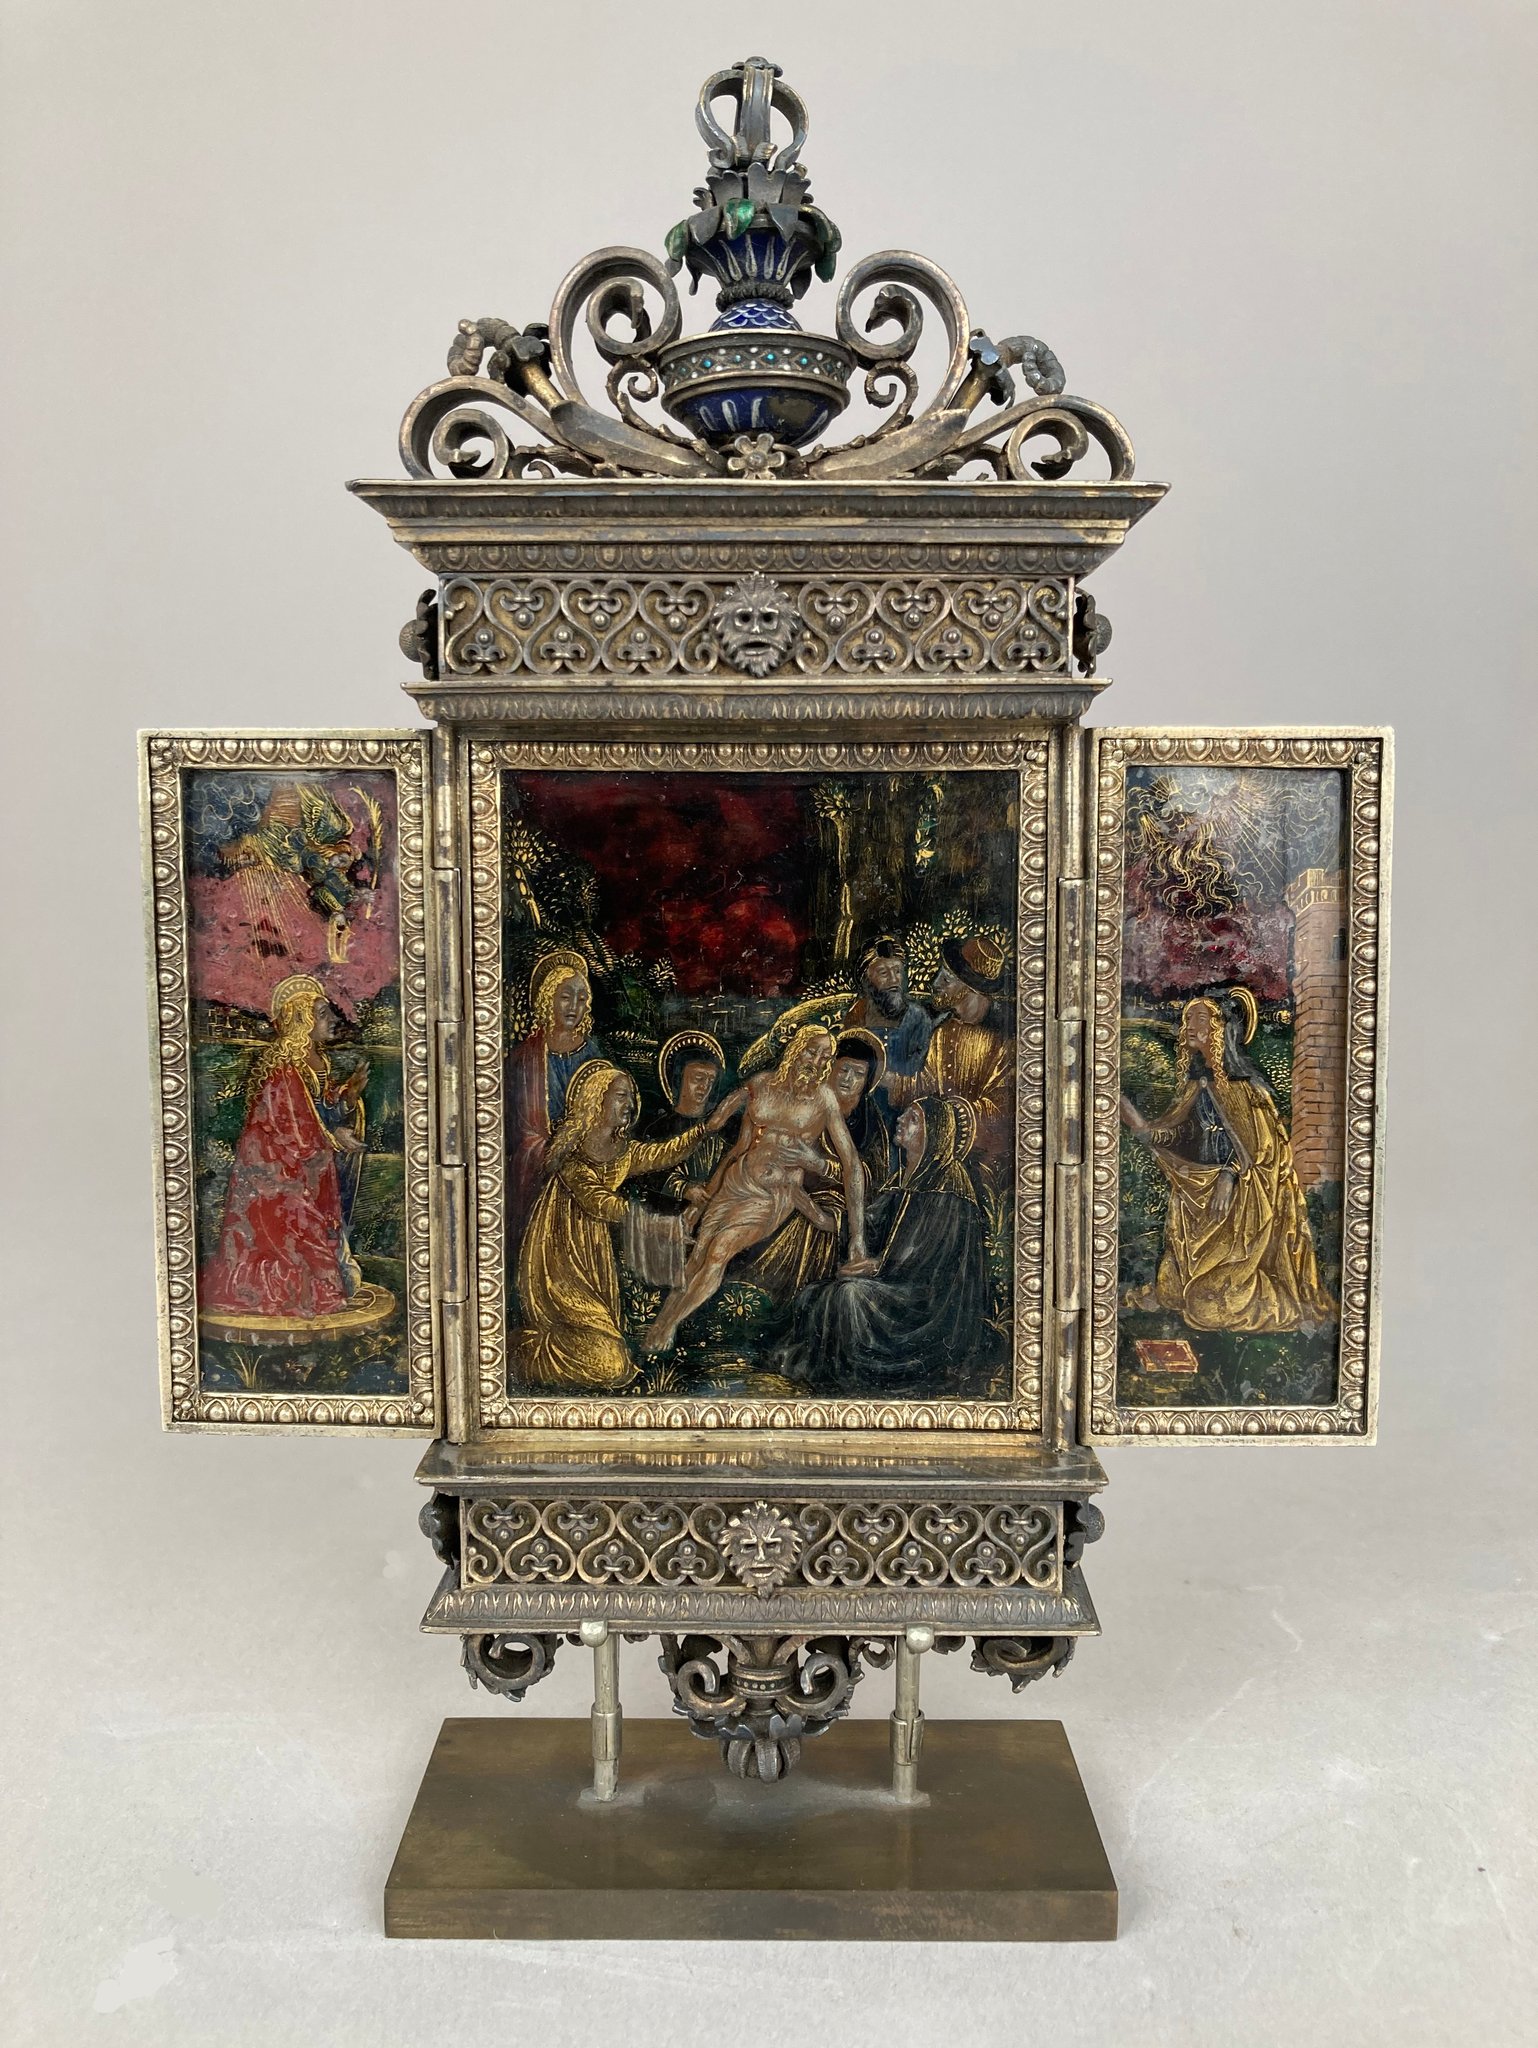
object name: triptych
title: Triptych: Lamentation over the Dead Christ, St. Catherine, St. Barbara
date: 1501-1600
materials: enamel, silver gilt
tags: christ,lamentation